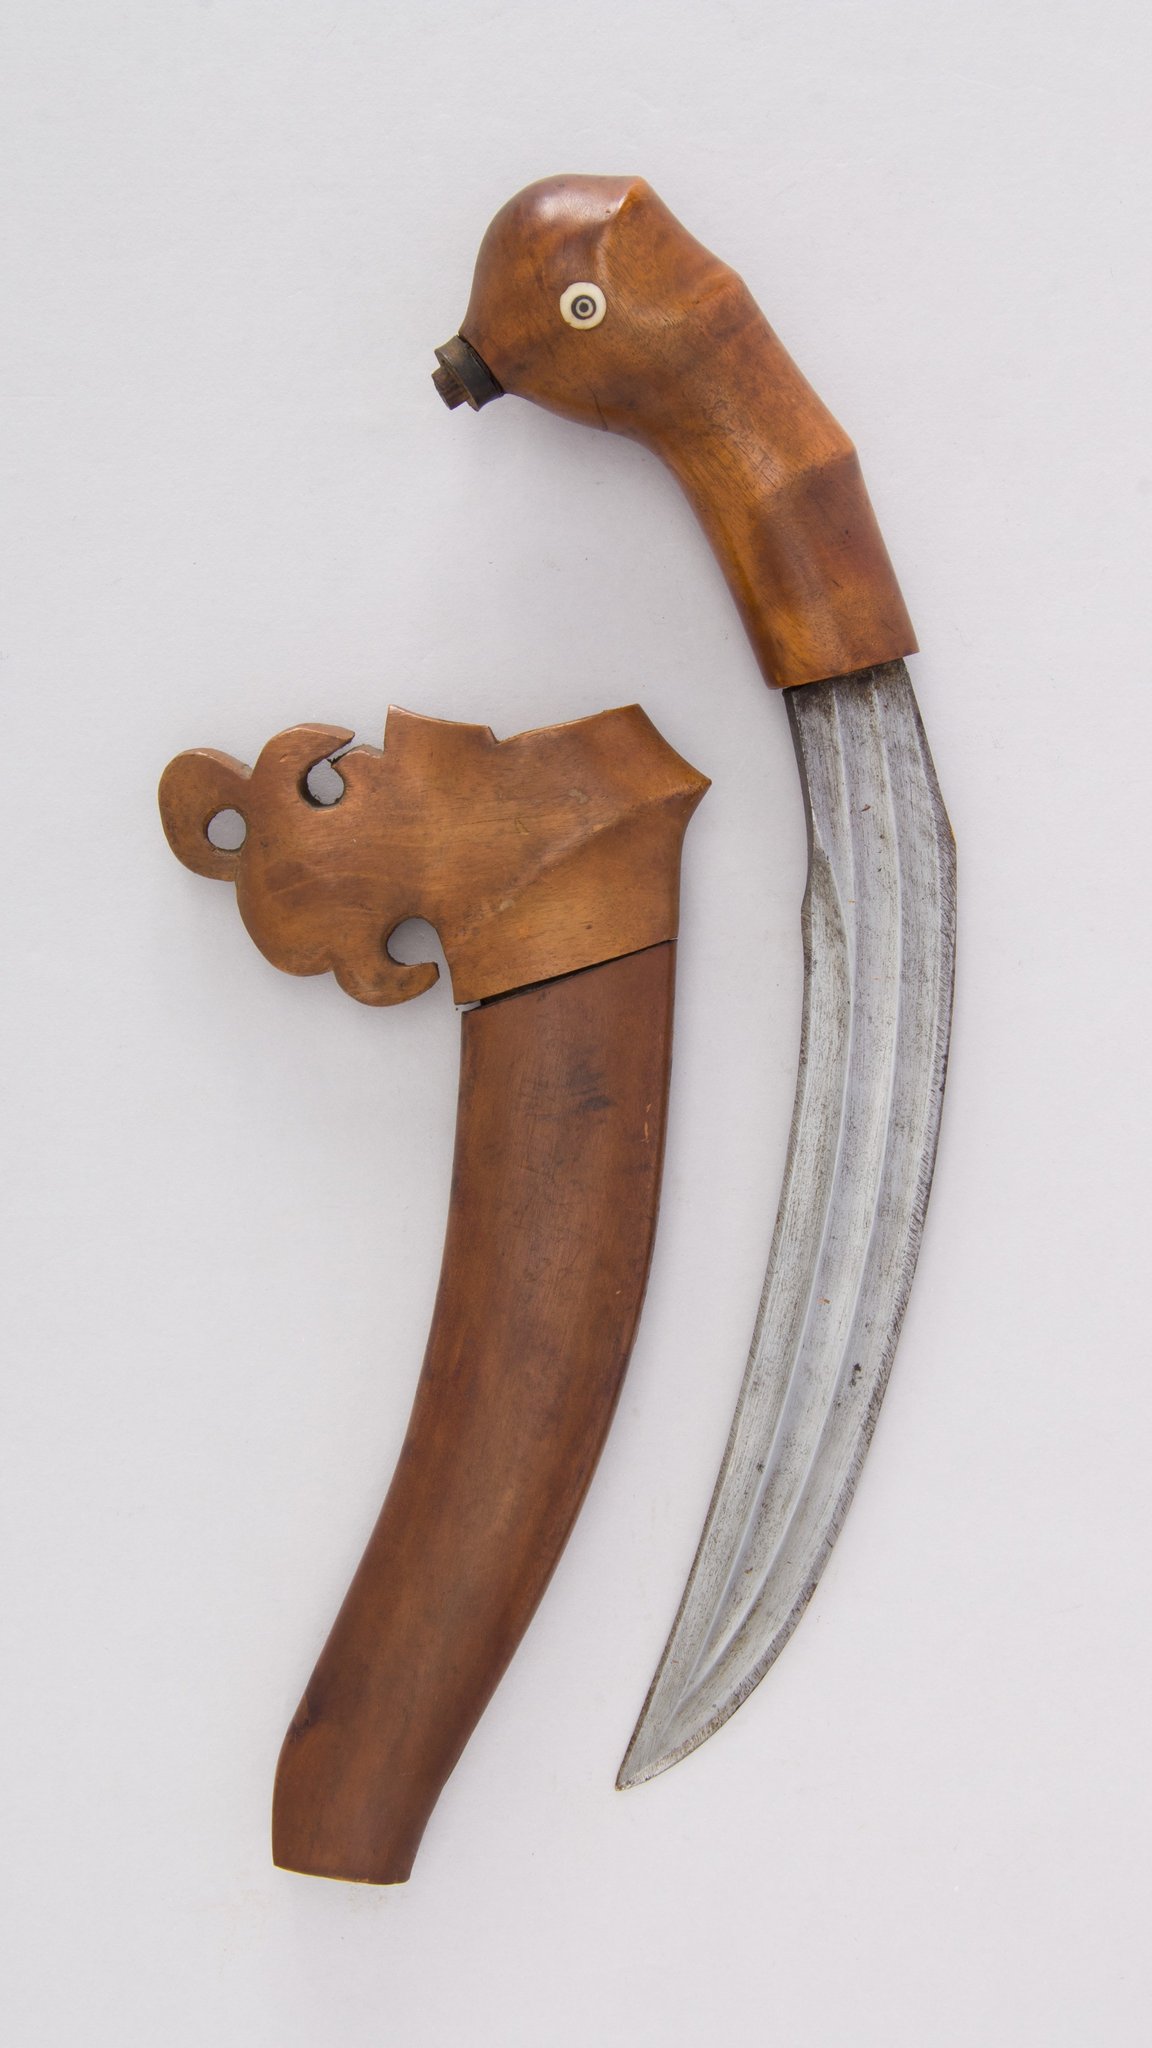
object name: dagger with sheath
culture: indonesian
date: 1701-1900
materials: steel, wood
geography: indonesia